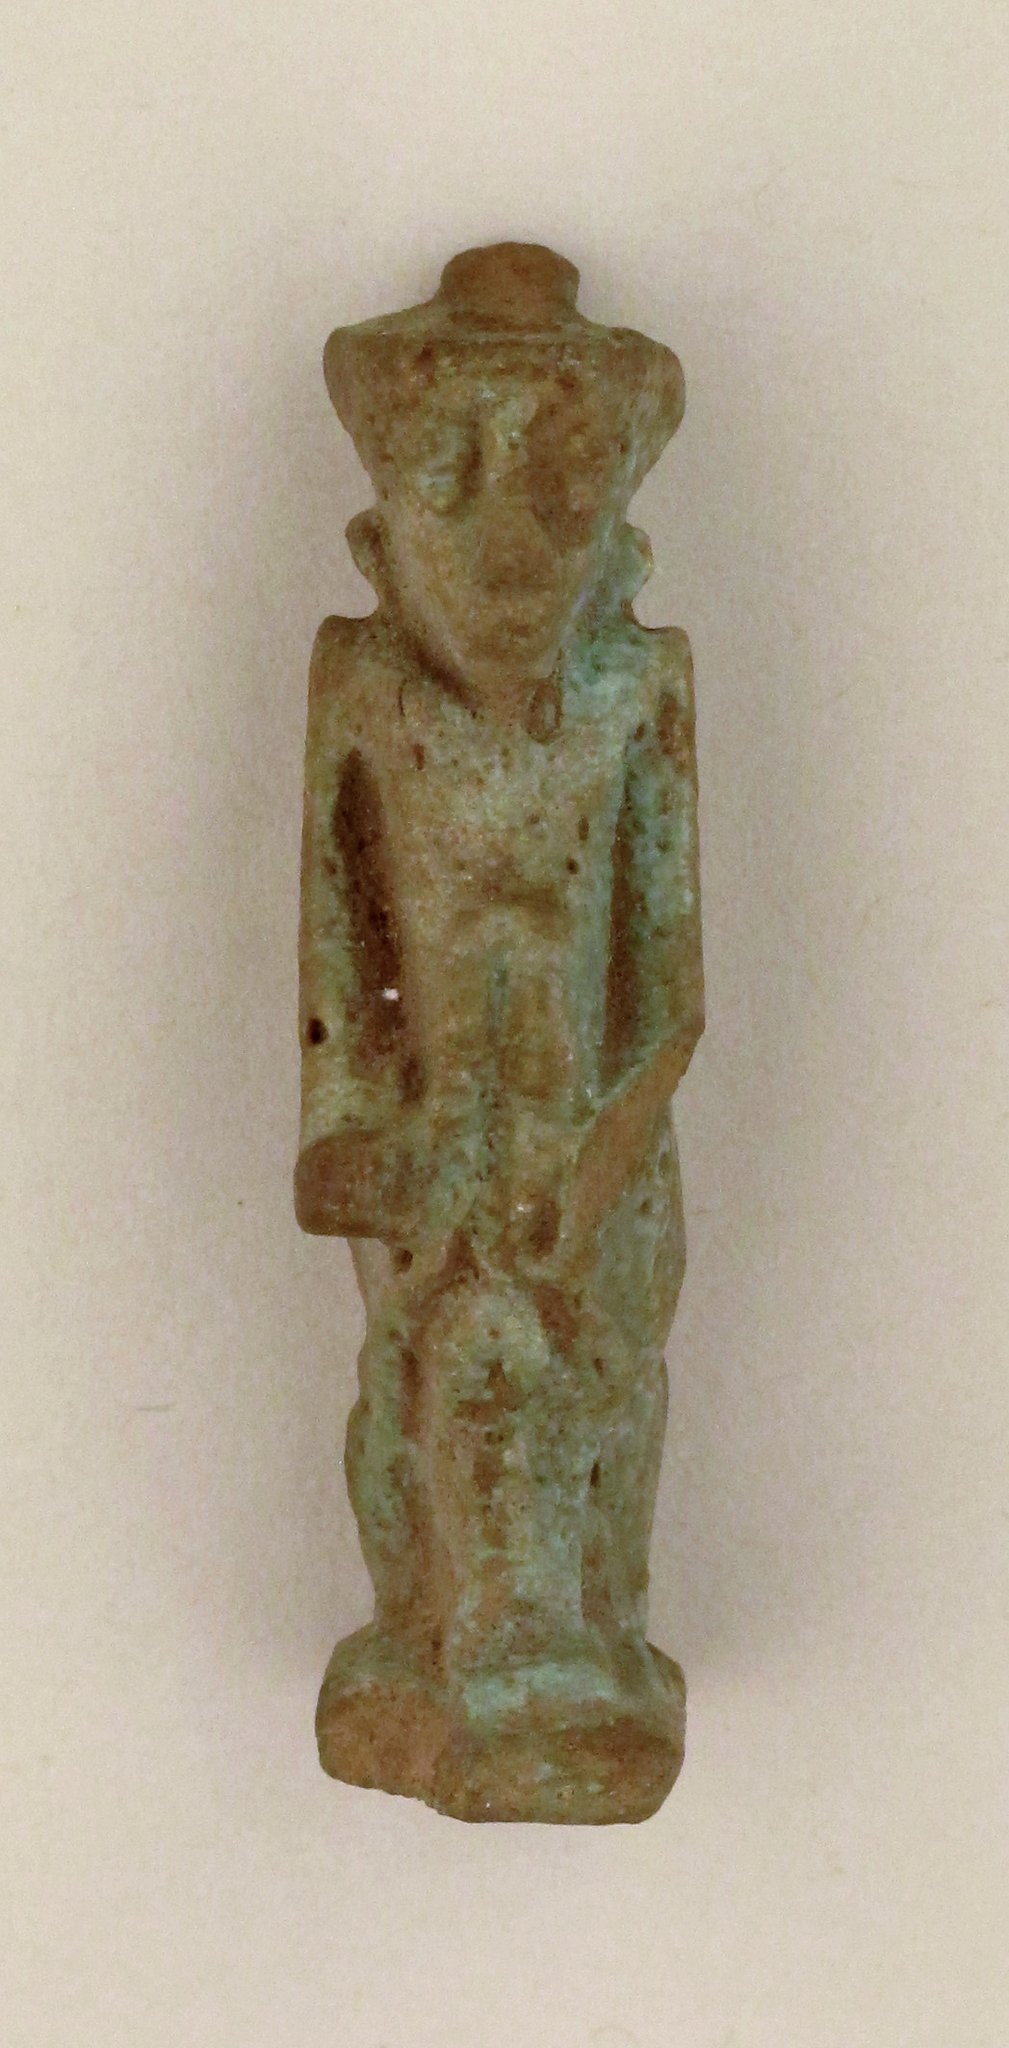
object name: amulet, taweret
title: Faience amulet of Taweret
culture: egyptian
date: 664-334 BCE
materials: faience